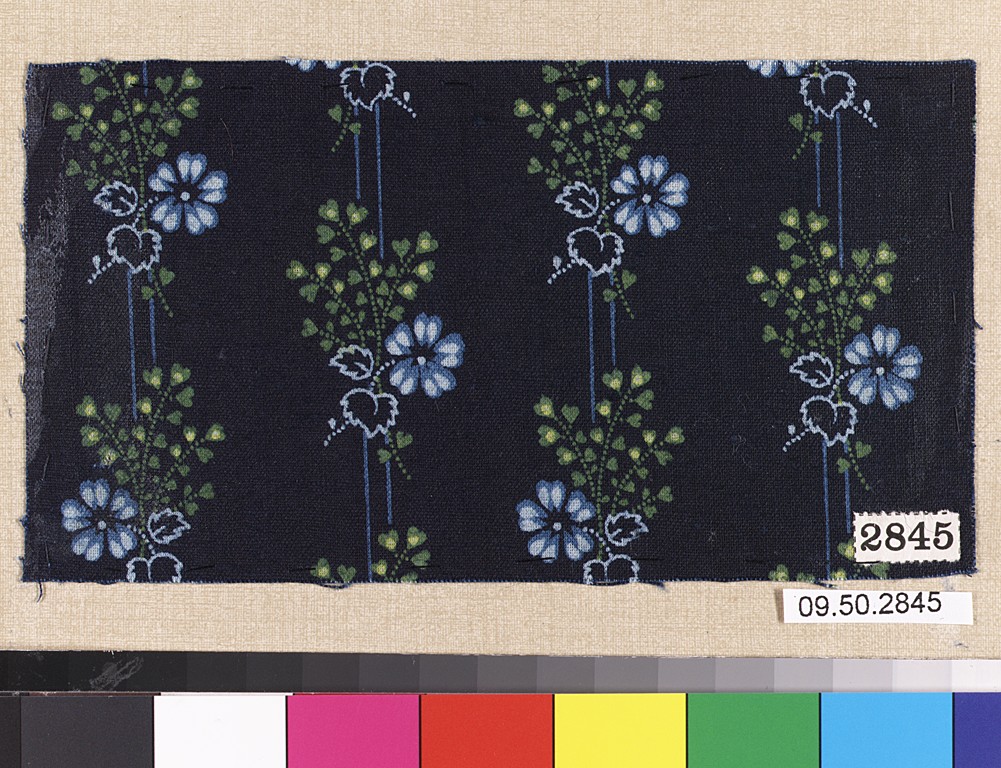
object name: piece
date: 1801-1900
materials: cotton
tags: flowers,leaves